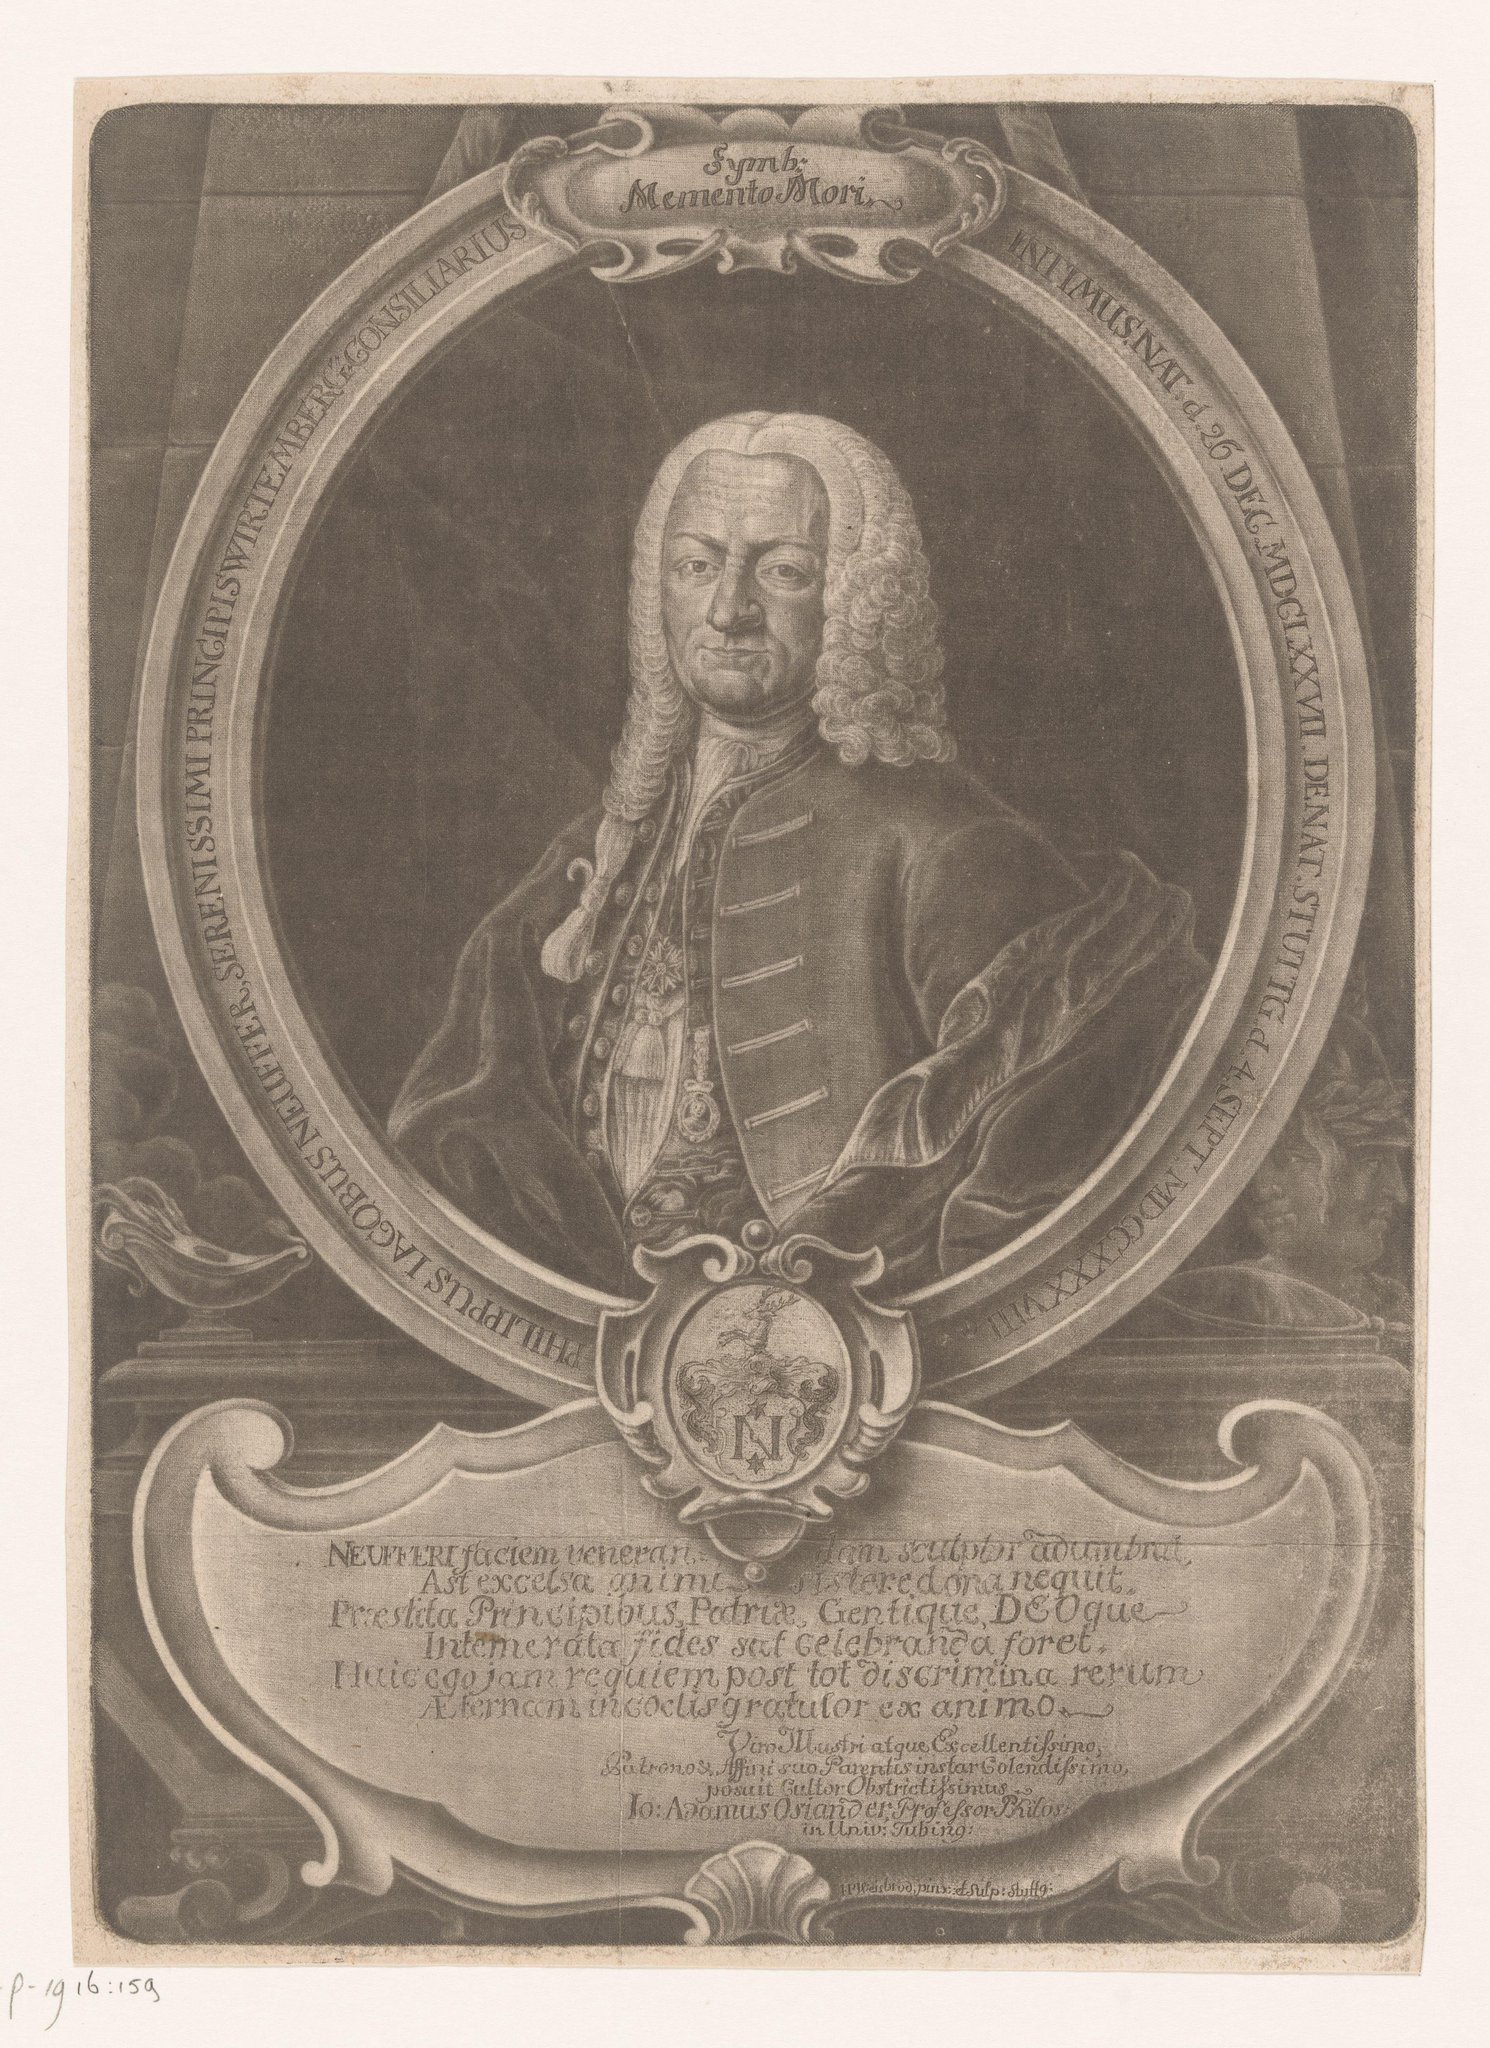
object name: print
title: Portret van Philipp Jacob Neuffer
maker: johann philipp weisbrod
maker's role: print maker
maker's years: 1704-1783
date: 1738-1783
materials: paper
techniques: mezzotint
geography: stuttgart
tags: historical persons, armorial bearing, heraldry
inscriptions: collector's mark: Lugt 2228